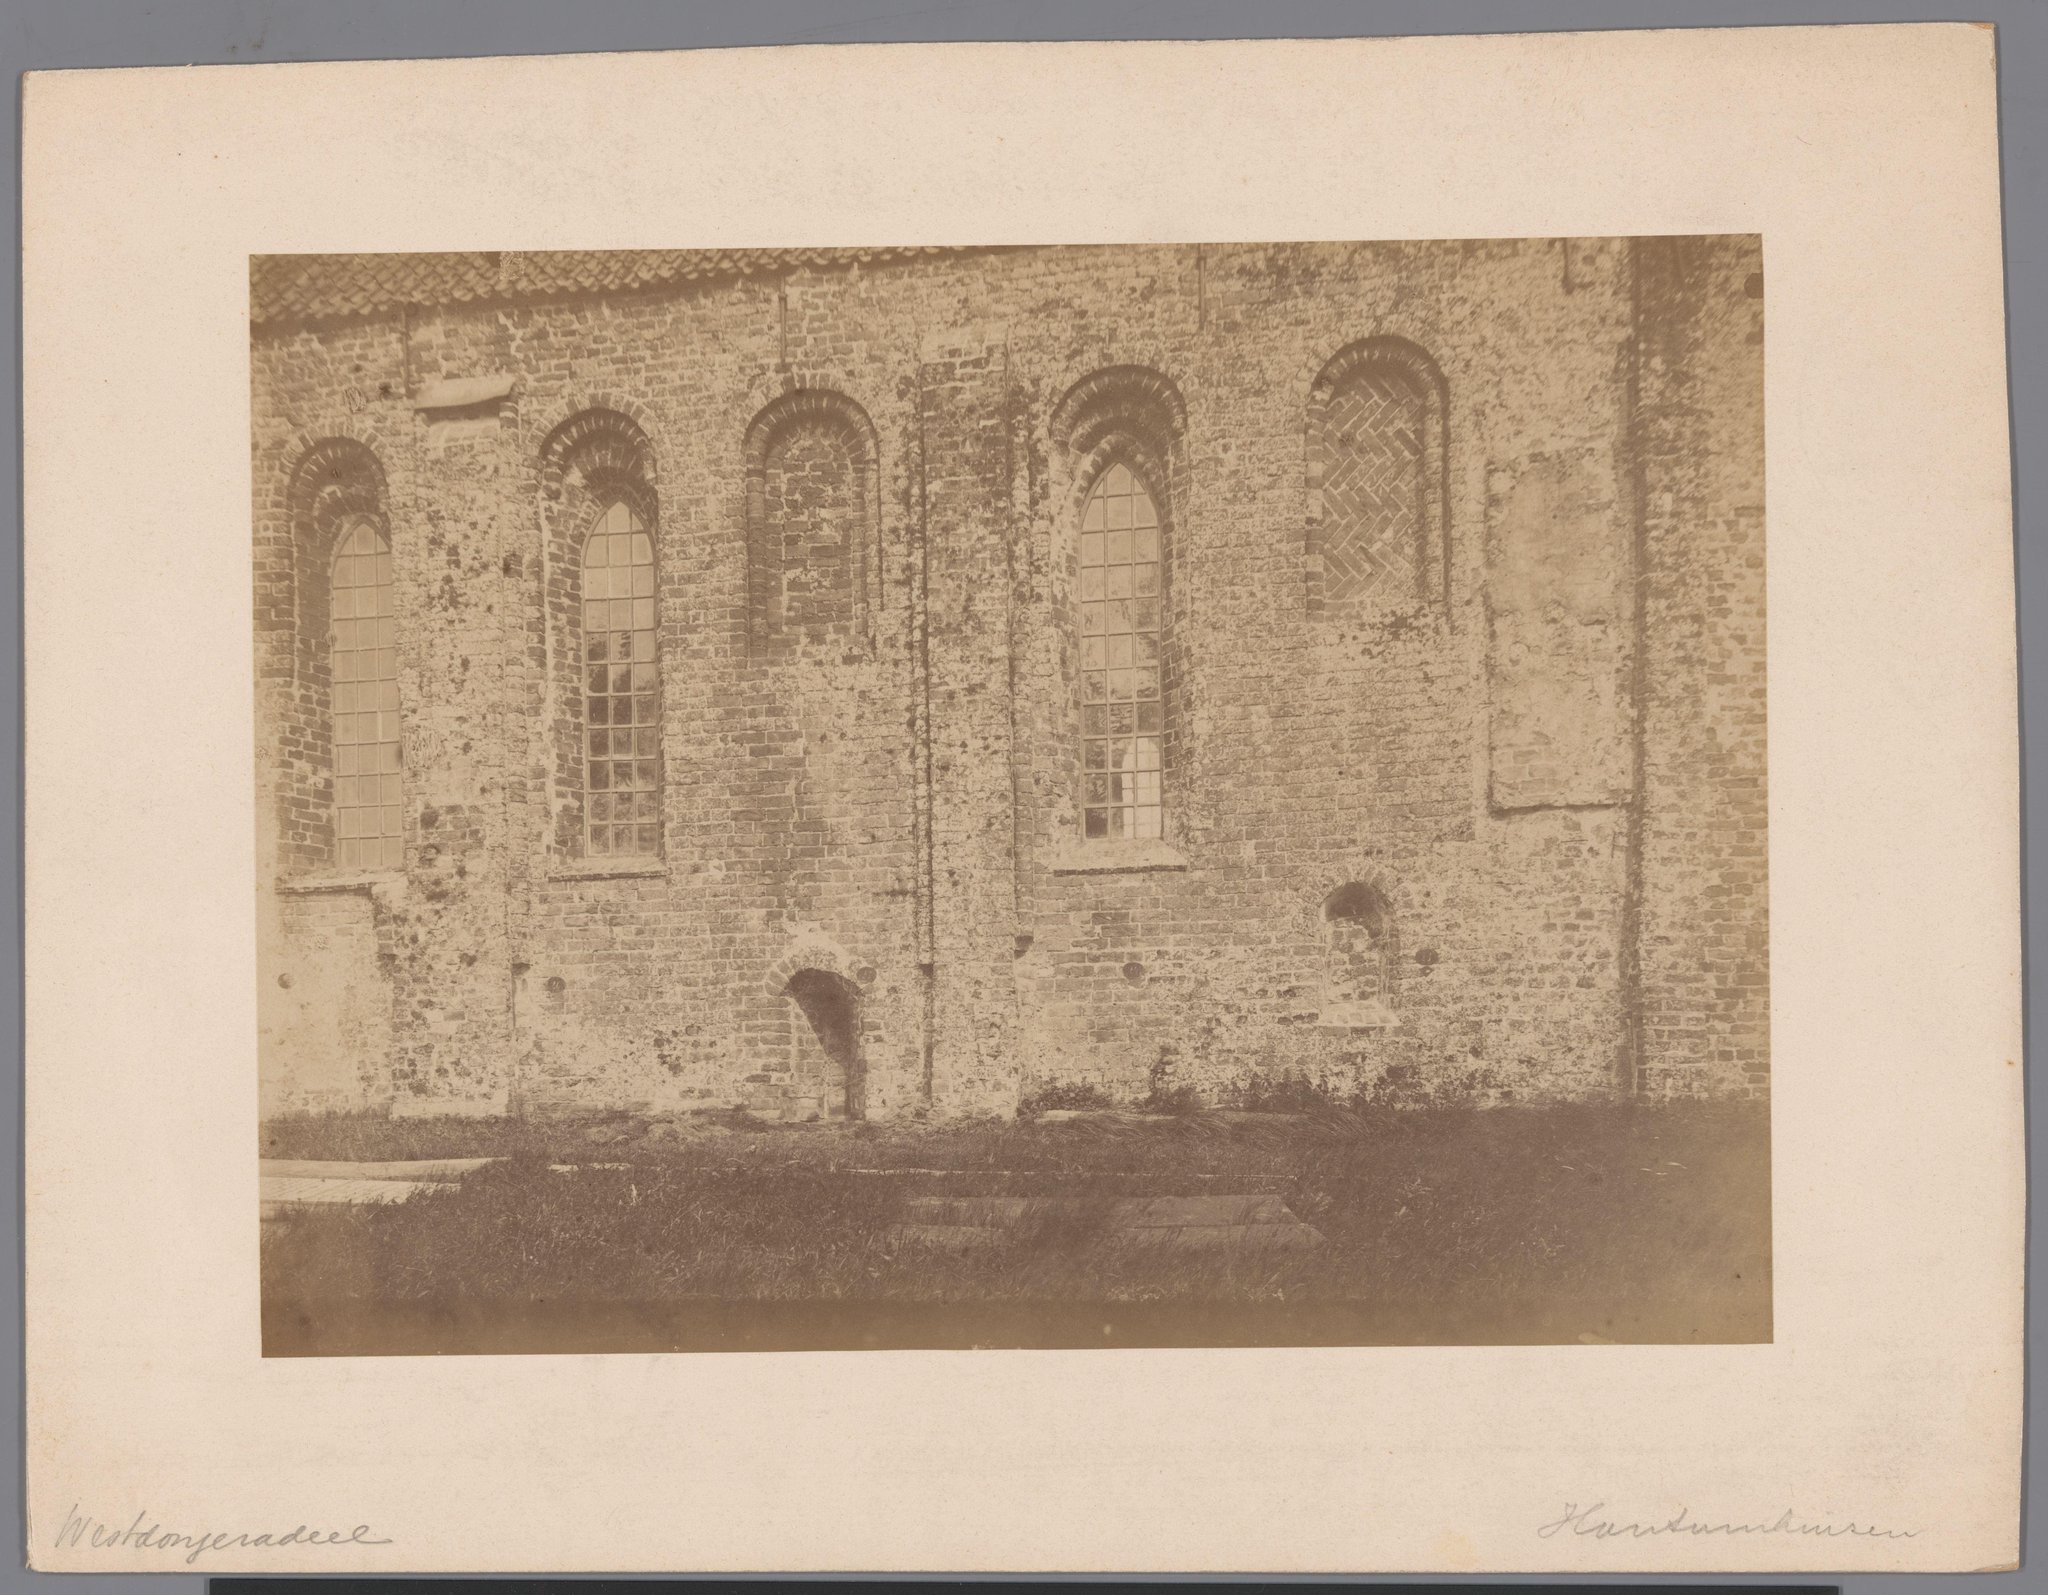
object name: photograph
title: Zuidelijke gevel van de Sint-Annakerk te Hantumhuizen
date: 1900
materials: cardboard, photographic support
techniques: albumen print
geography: hantumhuizen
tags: church (exterior)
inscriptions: annotation: ‘Westdongeradeel/ Hantumhuizen’, annotation: ‘Hantumhuizen (Fr.) / Zuid gevel N.H. Kerk / Augustus 1900’